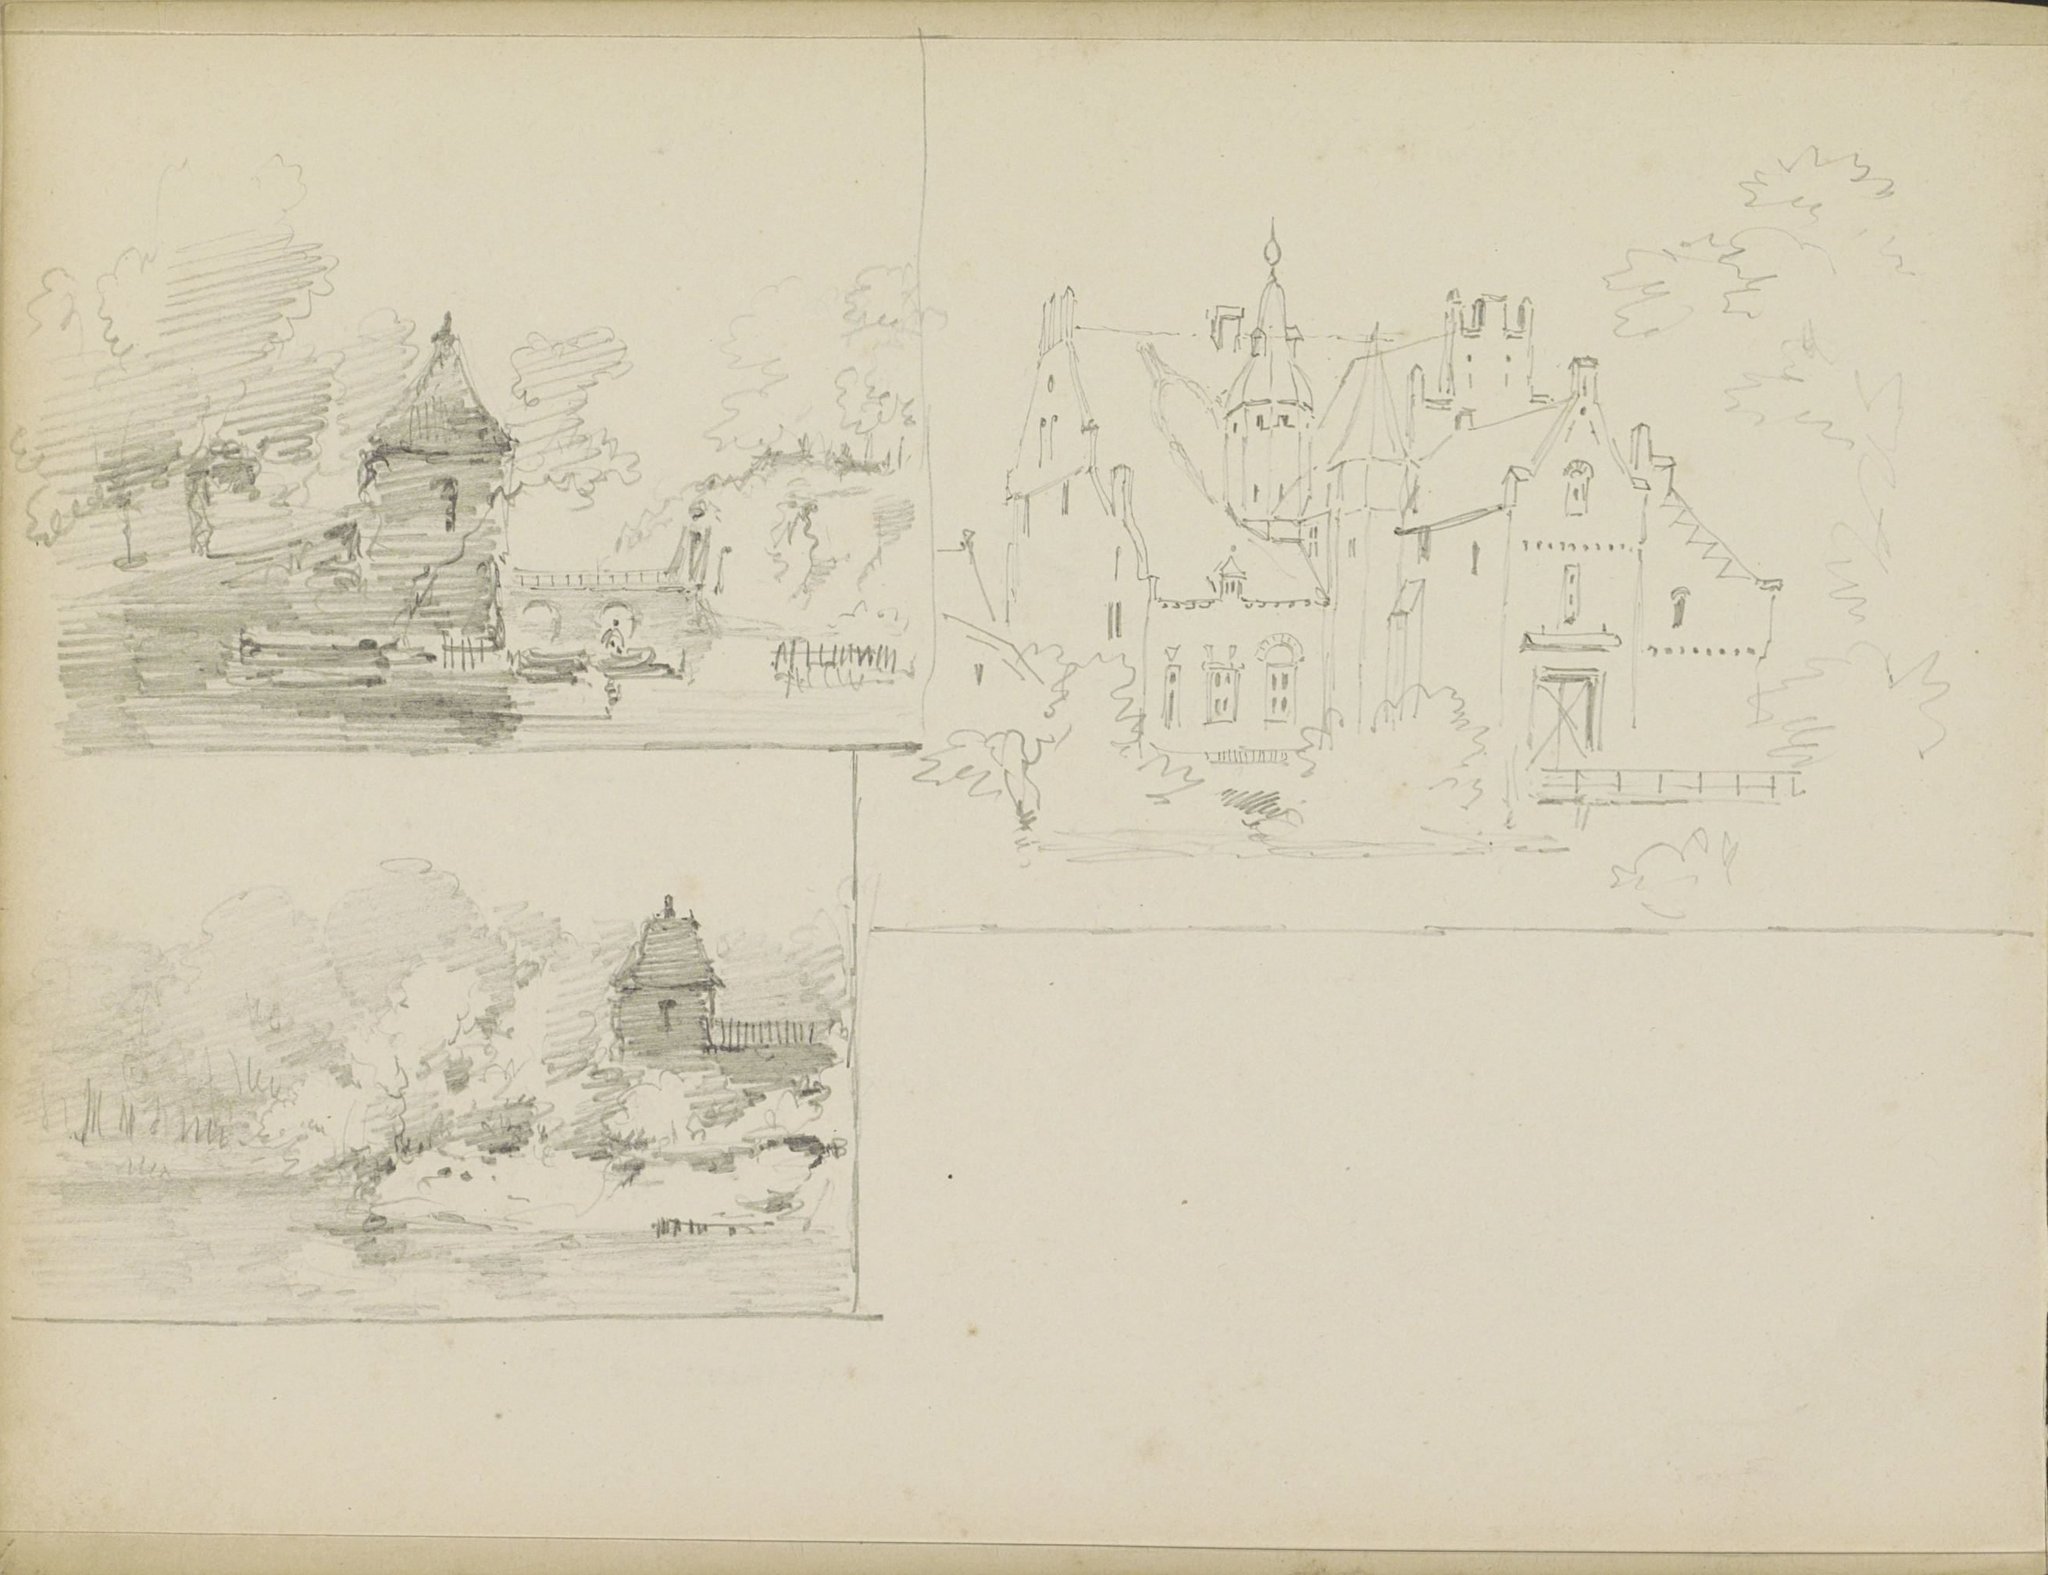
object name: sketchbook leaf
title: Twee landschappen en een gezicht op een kasteel of buitenplaats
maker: adrianus eversen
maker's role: draughtsman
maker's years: 1818-1897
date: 1828-1897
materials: paper, pencil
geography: netherlands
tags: landscape with bridge, viaduct or aqueduct, landscape with tower or castle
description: Linksboven een landschap met water en een brug met een toren. Linksonder een landschap met water en een toren. Rechts een gezicht op een kasteel of buitenplaats met torens. Blad 21 verso uit een schetsboek met 41 bladen.